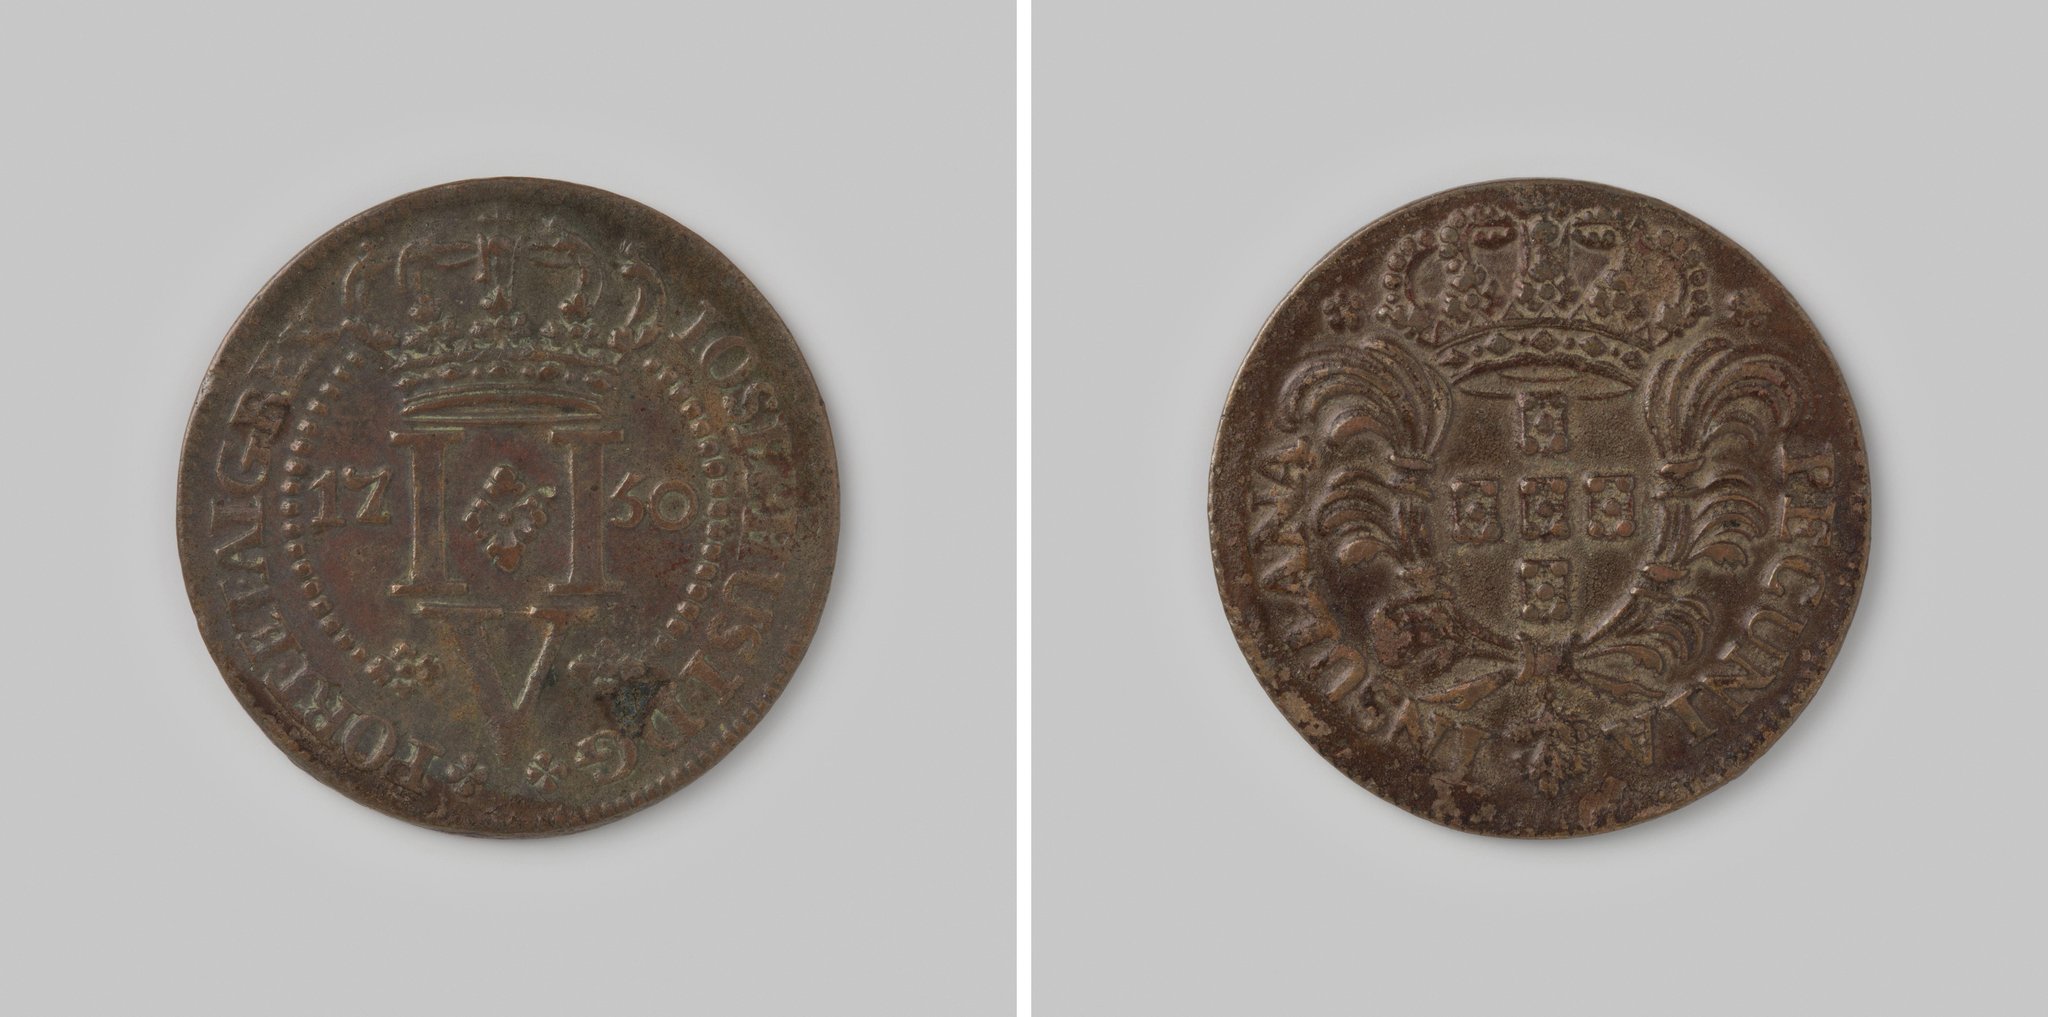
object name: coin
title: Azoren, koning José I van Portugal, 5 reis,1750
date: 1750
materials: copper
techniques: striking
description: Koperen munt. Voorzijde: tussen jaartal twee letters I [=Josephus I]. Daarboven een kroon en daaronder waarde-aanduiding: V. Keerzijde: tussen twee samengebonden takken wapen van Portugal, waarboven kroon. Omschrift: percunia insulana [=munt van de eilanden]. Gladde rand.